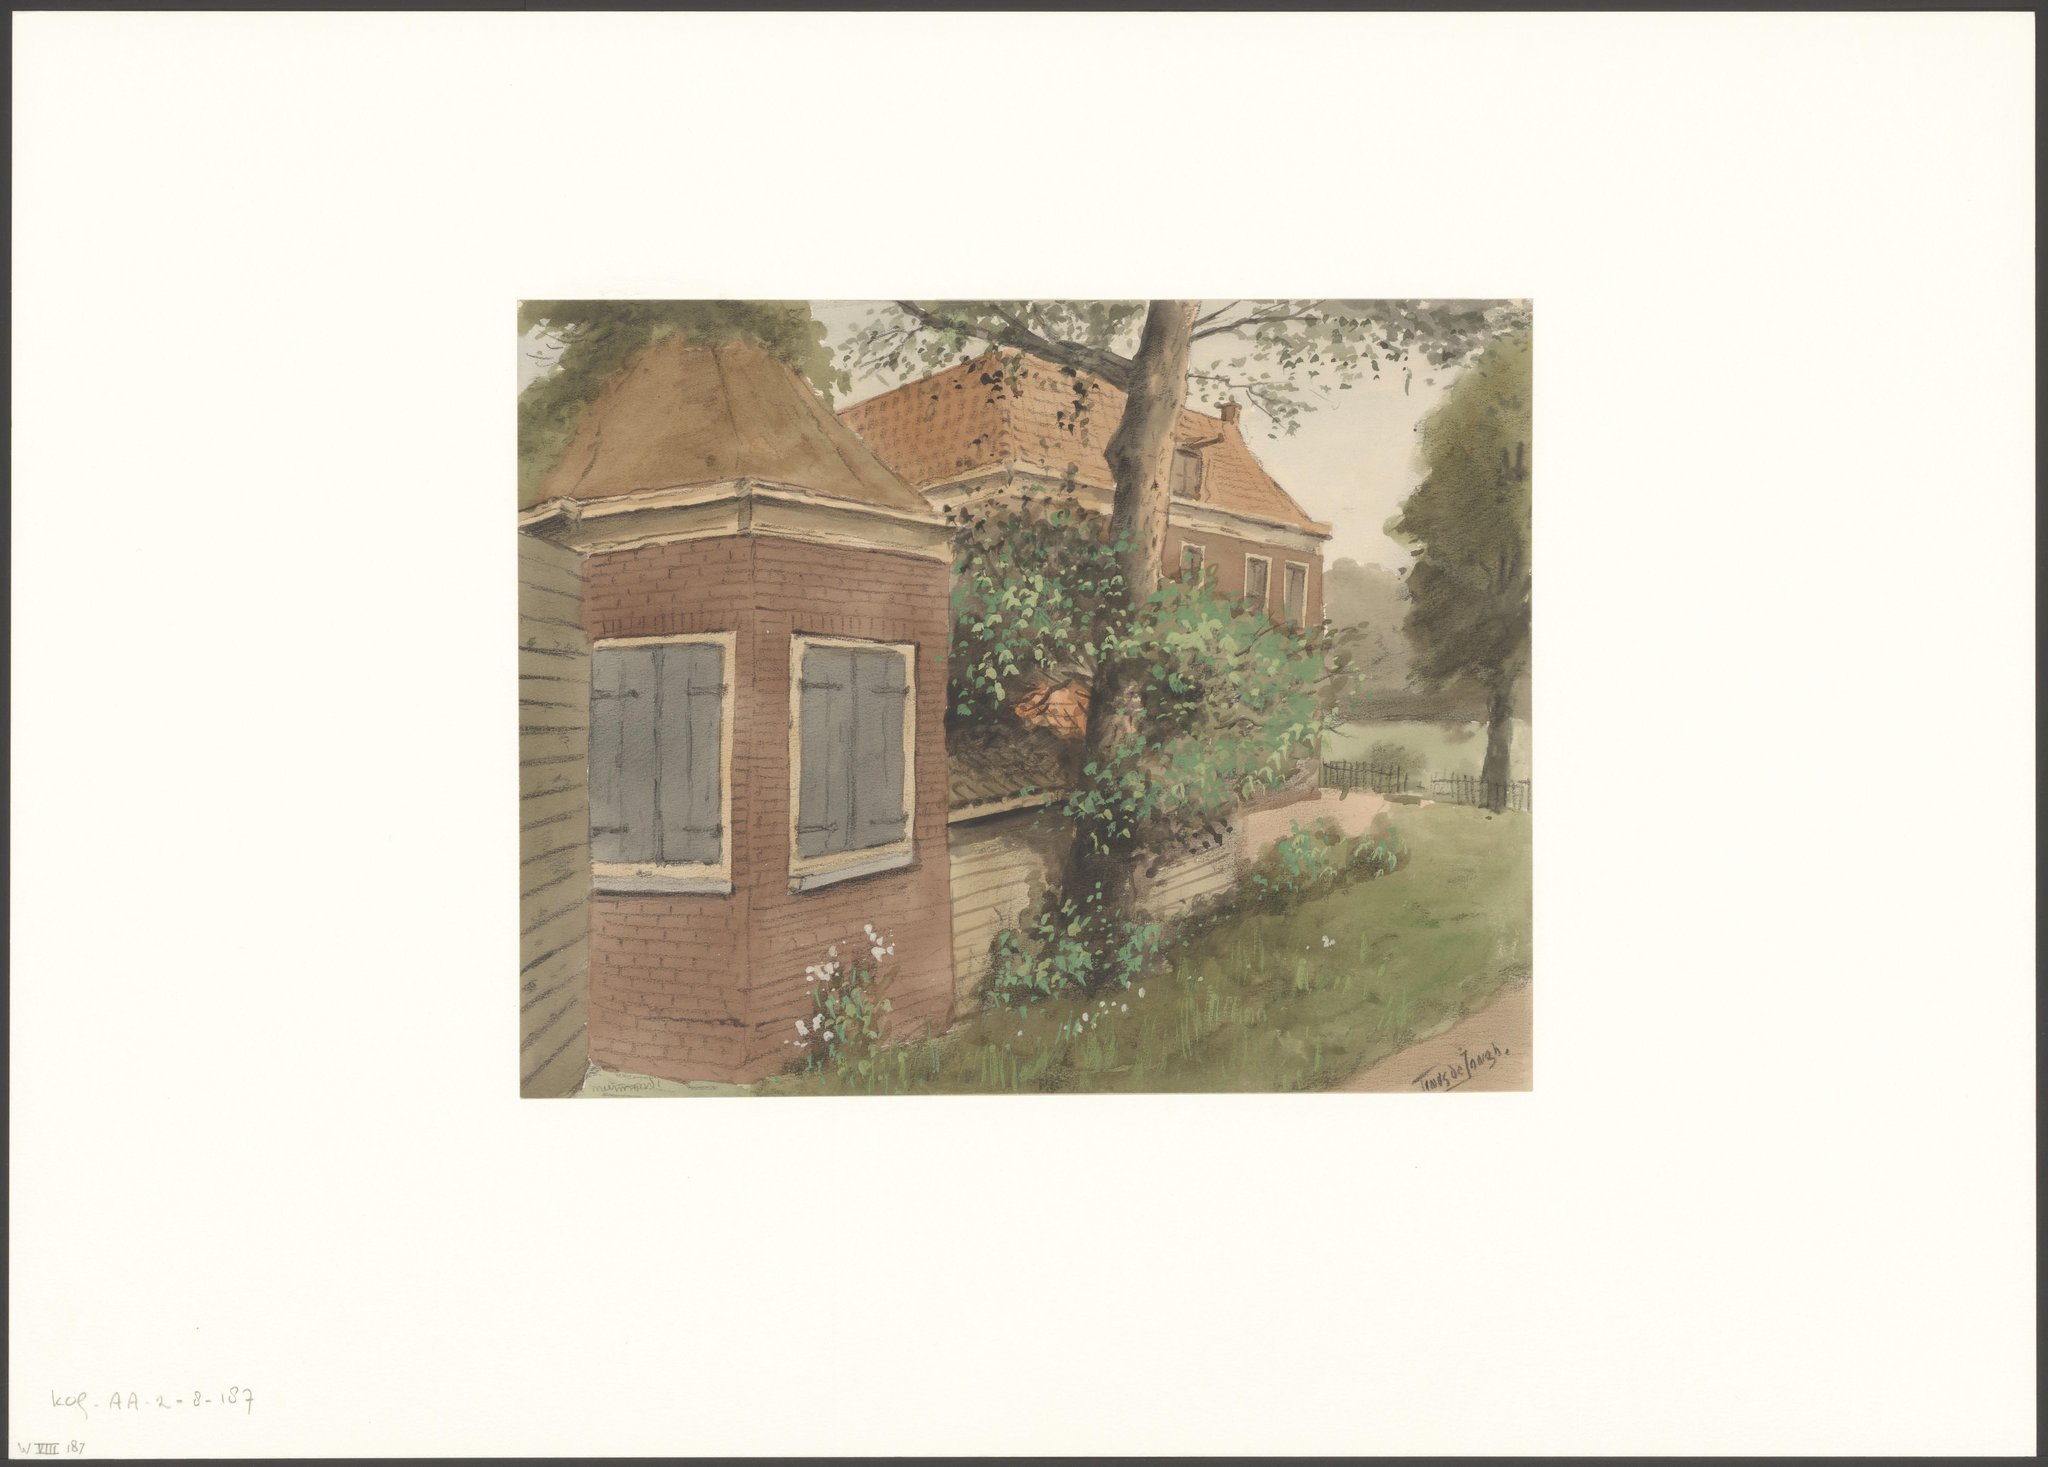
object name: drawing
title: Gezicht op een huis aan de Amsteldijk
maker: tinus de jongh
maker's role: print maker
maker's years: 1885-1942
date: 1914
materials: chalk, gouache, paper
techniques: brush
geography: amsterdam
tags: city-view in general; 'veduta', road, path, farm or solitary house in landscape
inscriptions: collector's mark: Lugt 800a, signature: ‘TinusdeJongh.’, inscription: ‘meermond / gezien van den buiten Amstel / naar Amsterdam 1914’, inscription: ‘meermonde’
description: Tekening binnen de Atlas Van Eck ingedeeld op wijknummer 8.